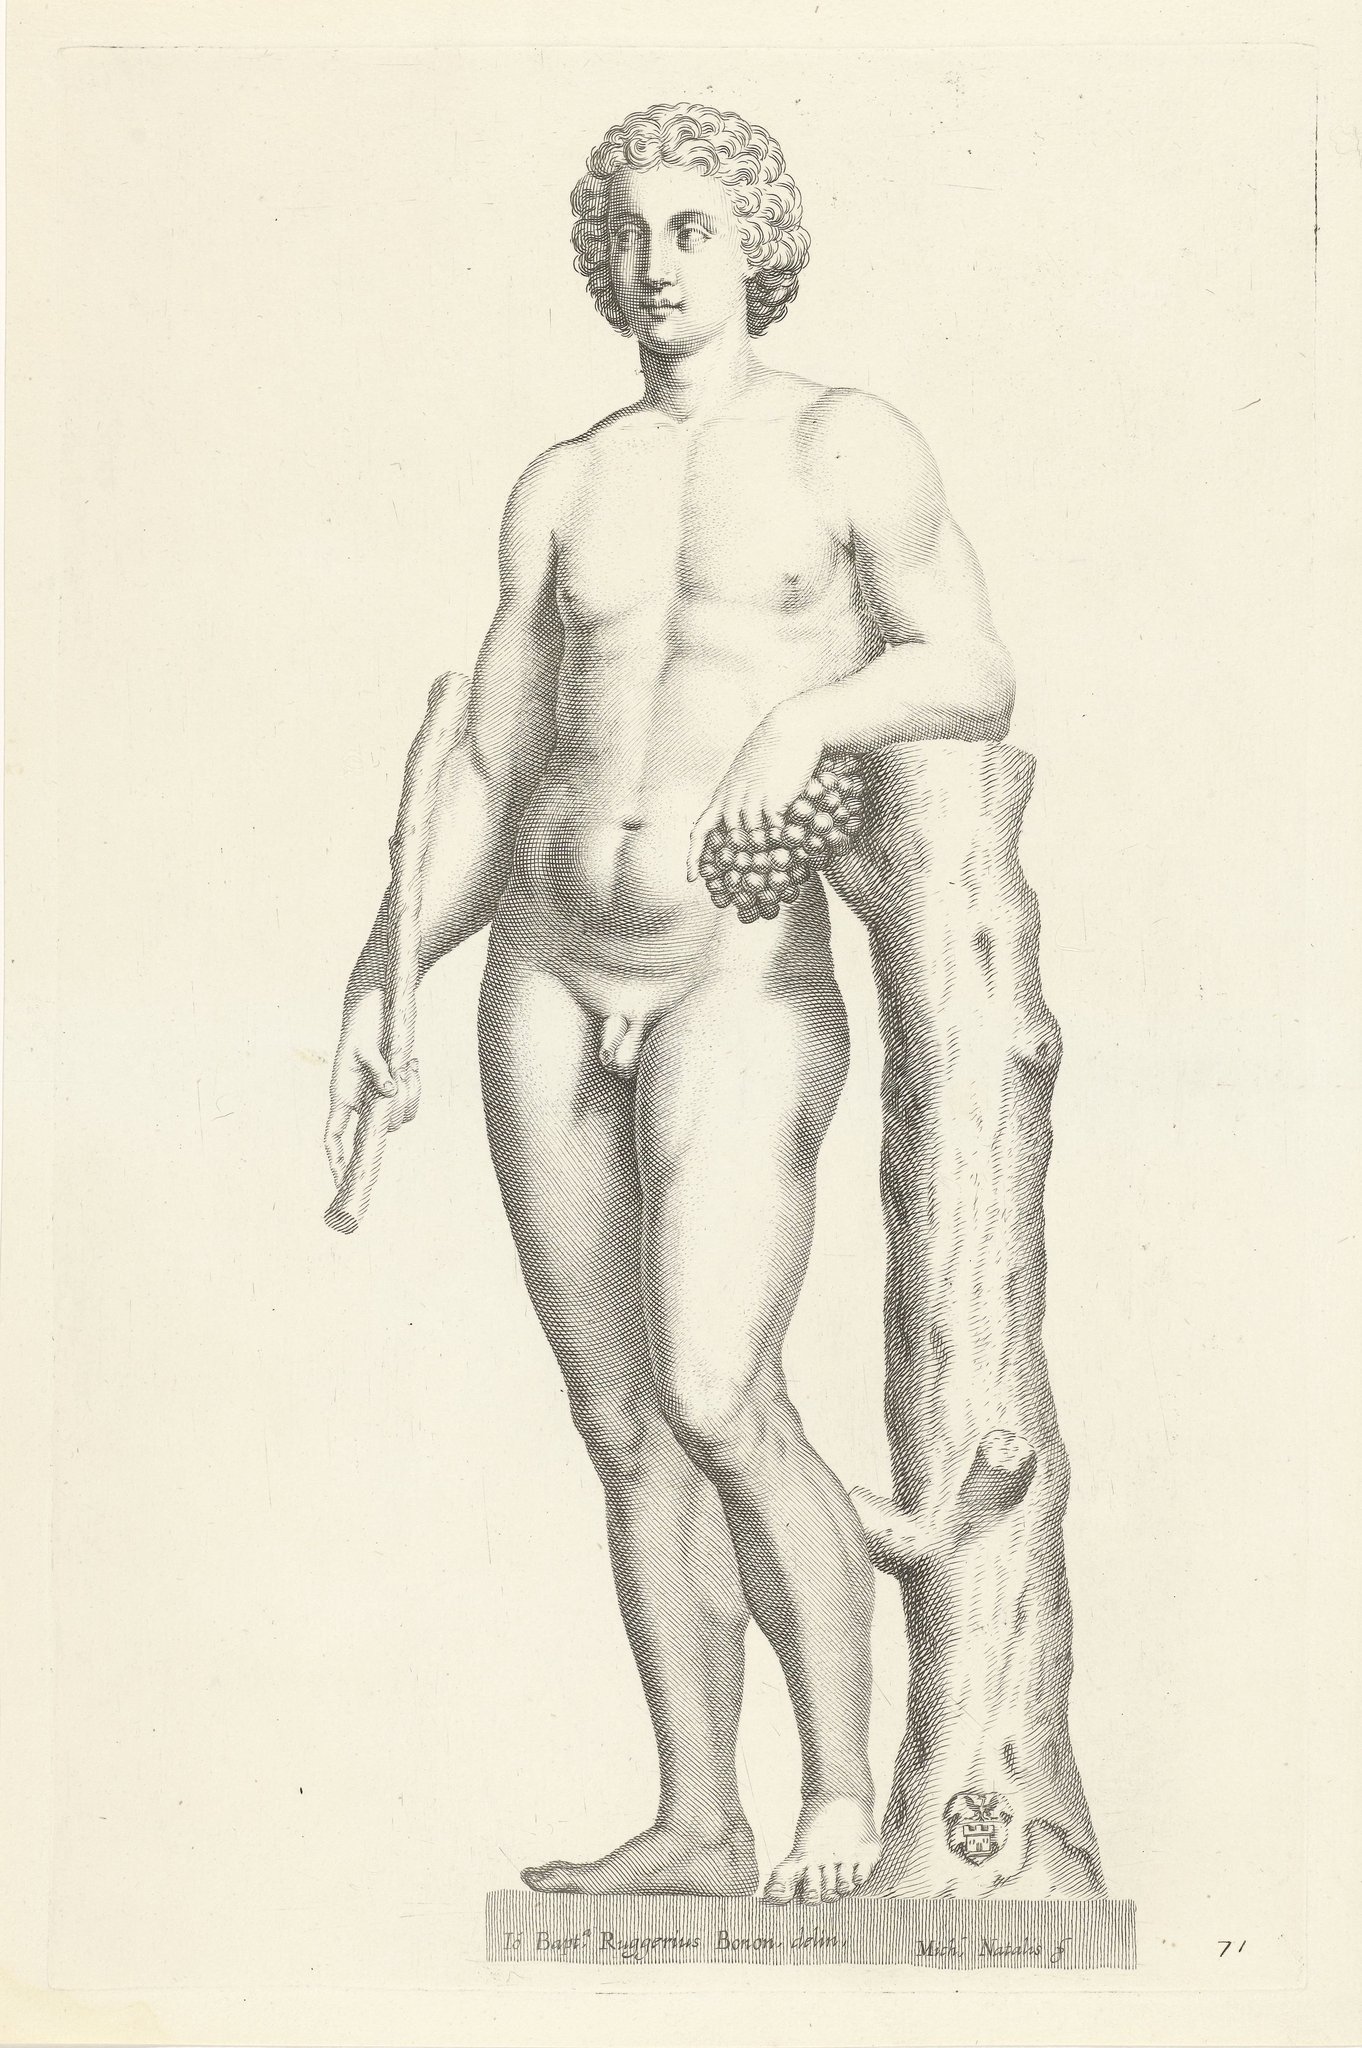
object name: print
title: Galleria Giustiniana del Marchese Vincenzo Giustiniani I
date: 1640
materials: paper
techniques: engraving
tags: rome, vincenzo giustiniani (1564-1637), offspring, companion(s), train etc. of bacchus, piece of sculpture, reproduction of a piece of sculpture, monument, statue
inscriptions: collector's mark: Lugt 2228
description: Standbeeld van een mannelijke volgeling van Bacchus, in zijn ene hand een stok, in de andere hand een druiventros. Met zijn linkeronderarm rust hij op een boomstam. Onder op de boomstam het wapenschild van Vincenzo Giustiniani. Prent uit een serie naar de sculpturen in de verzameling in de Galleria Giustiniani te Rome.